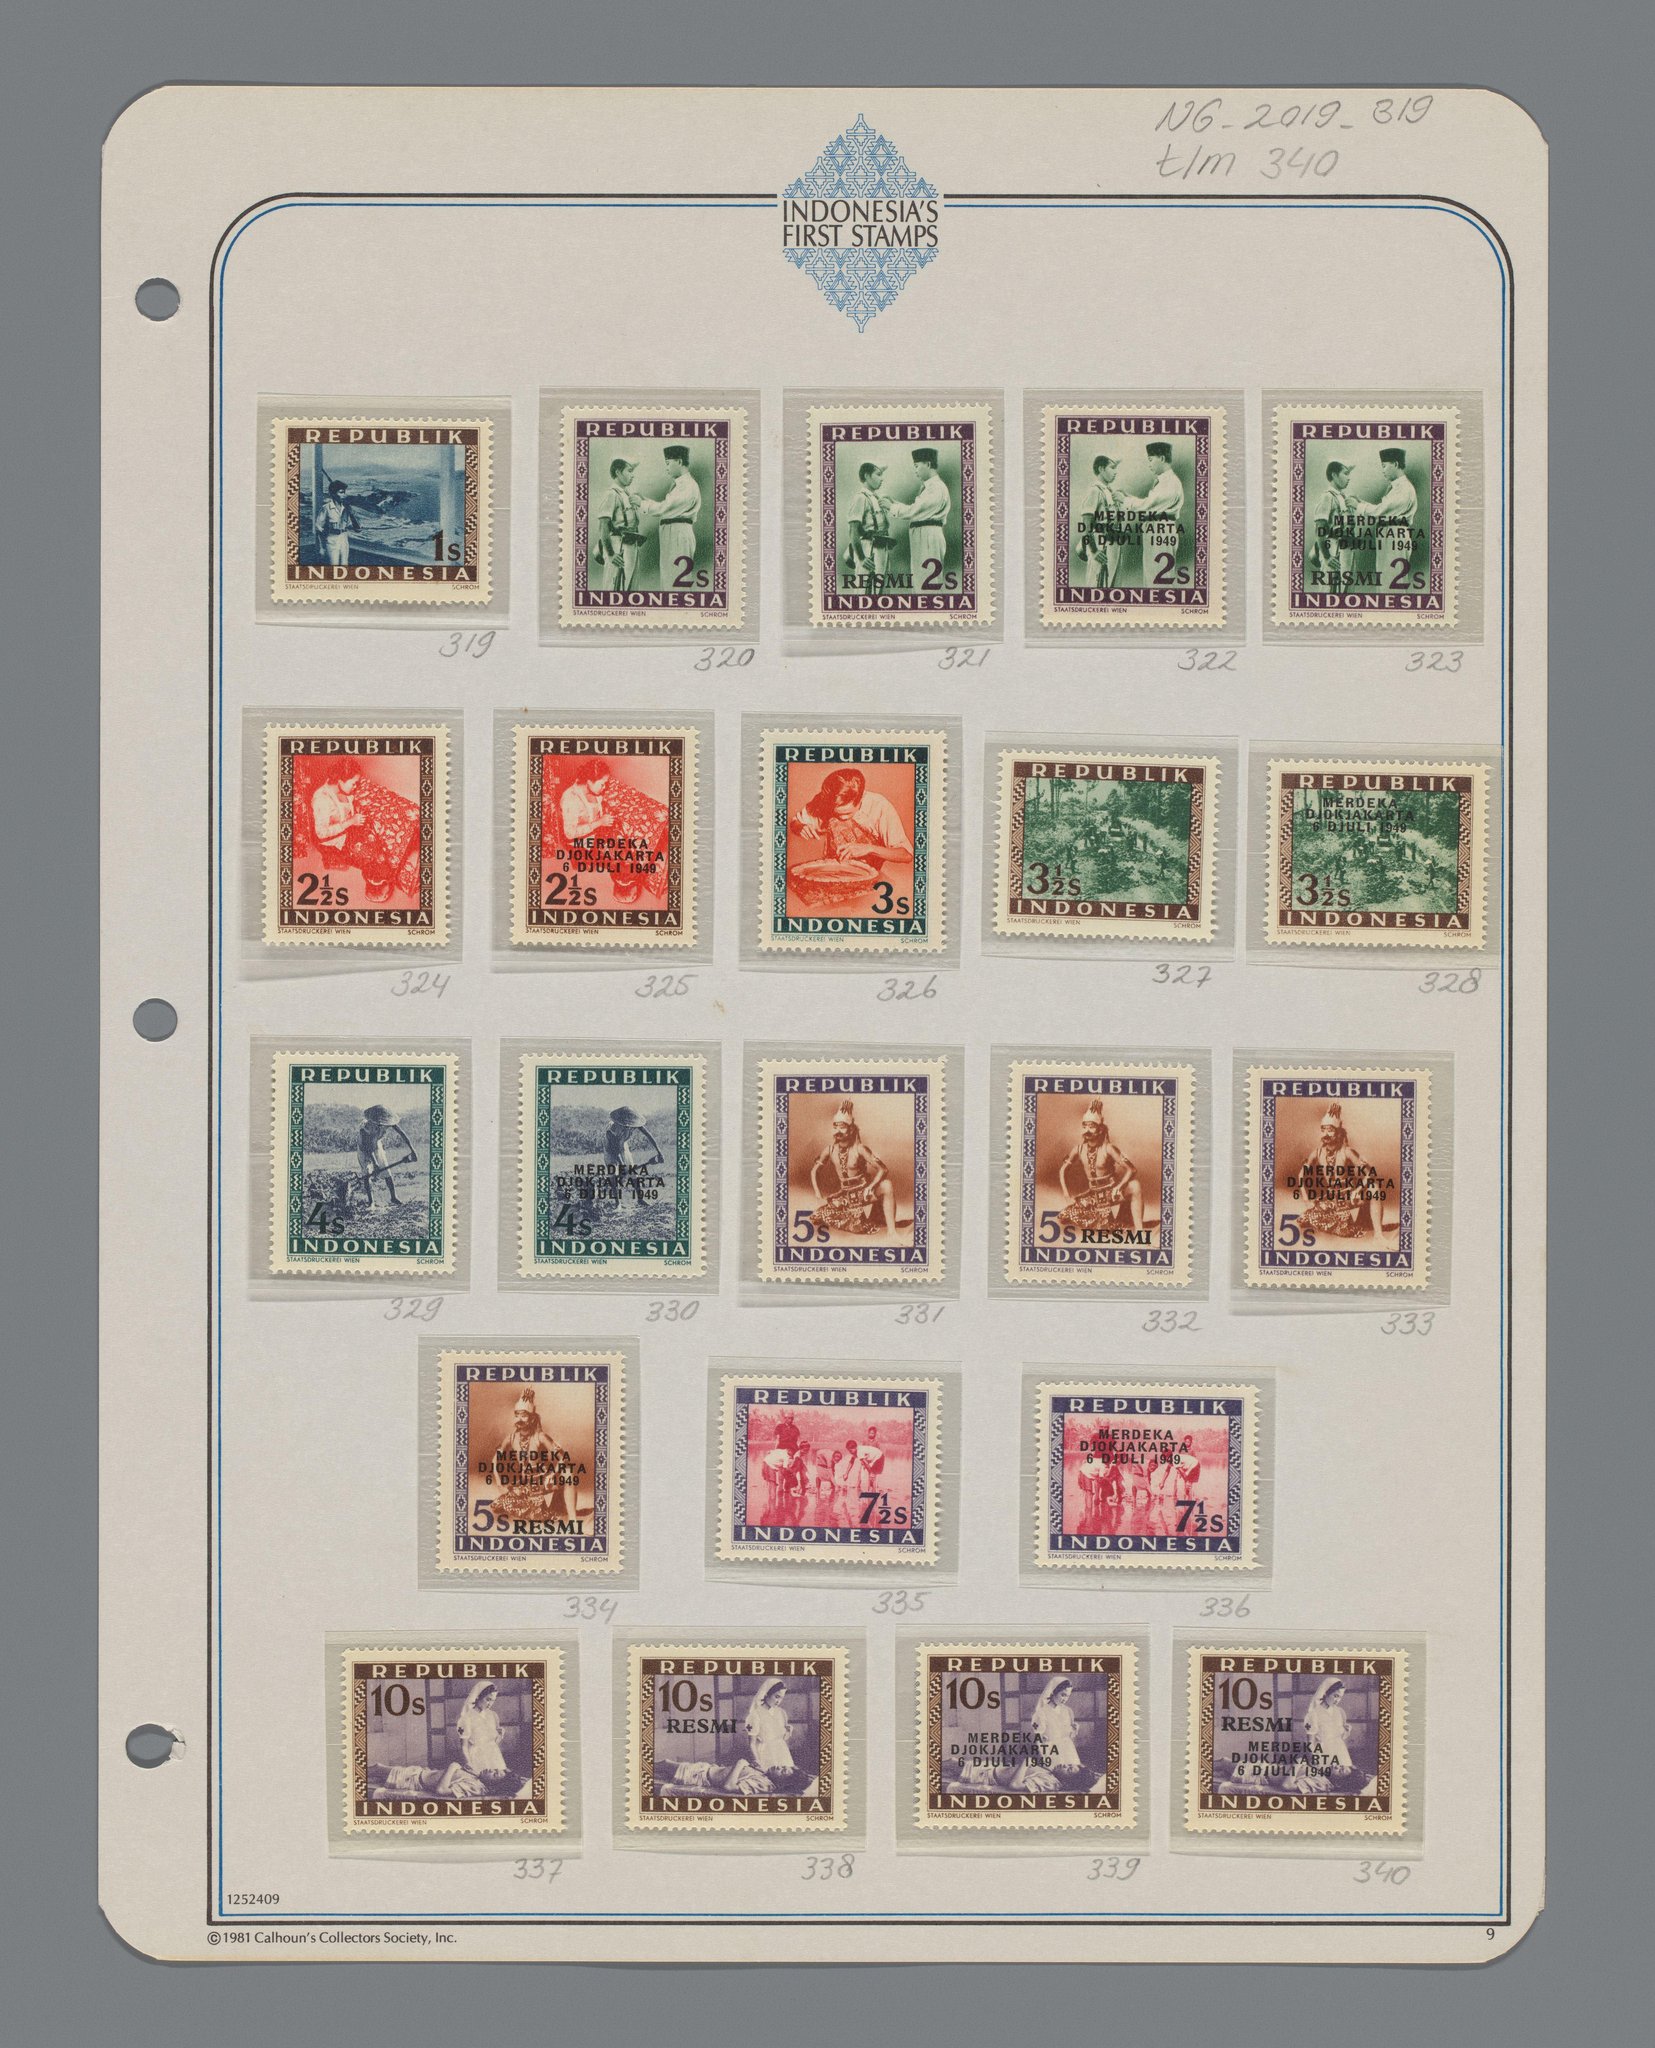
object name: postage stamp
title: Postzegel Republik Indonesia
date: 1949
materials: paper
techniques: photoaquatint, engraving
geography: vienna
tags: indonesia